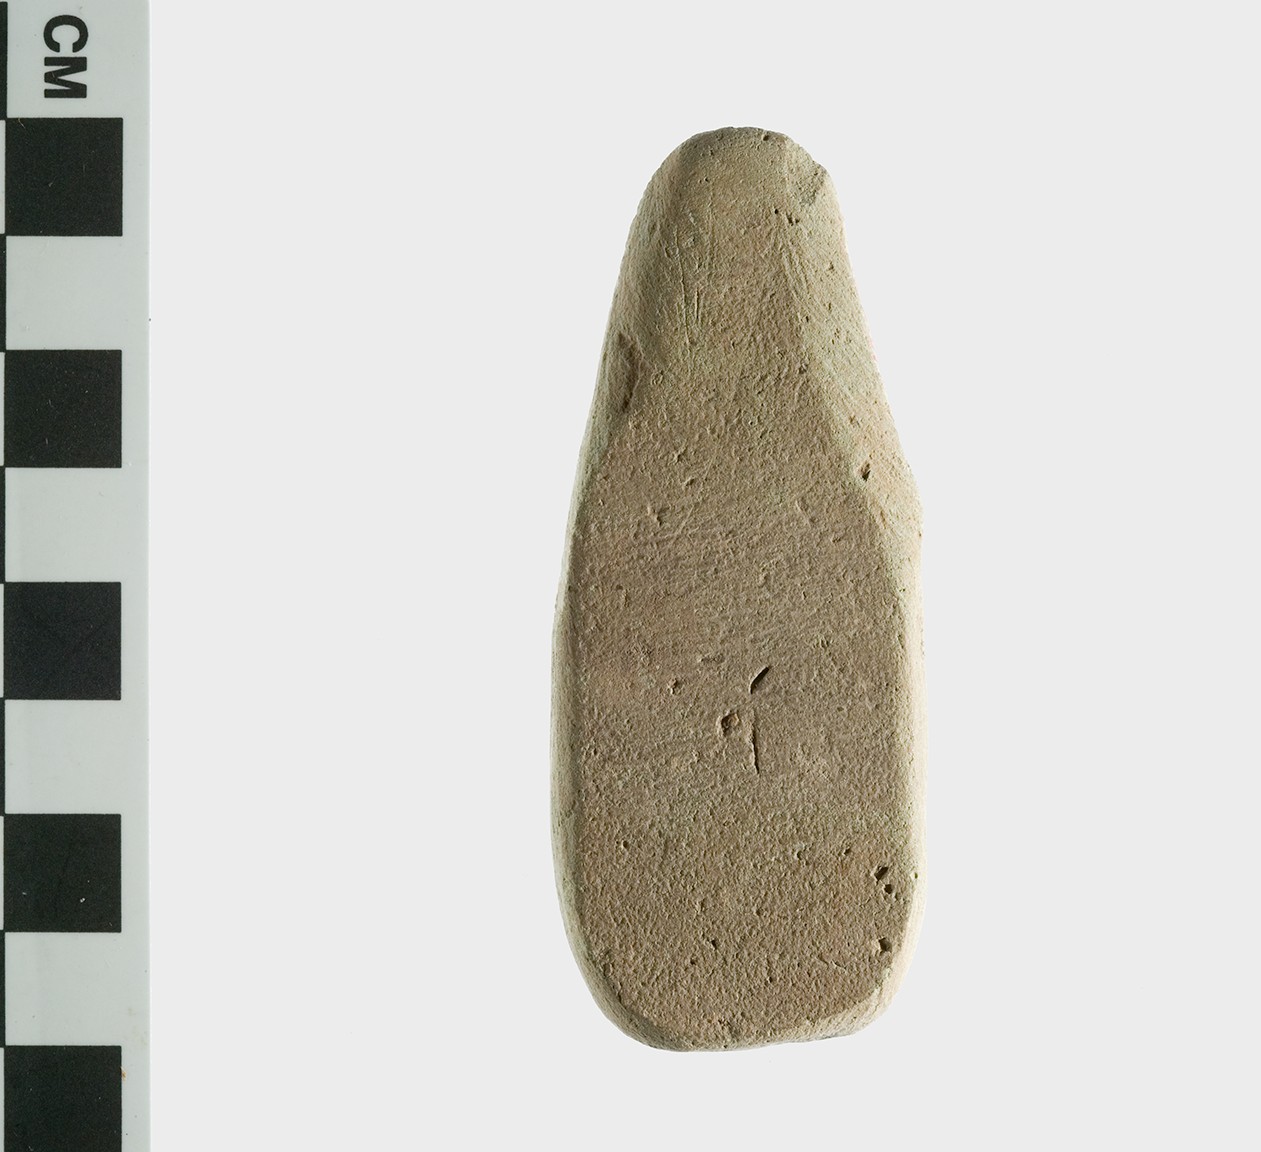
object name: polishing stone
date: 1295-1070 BCE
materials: stone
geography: egypt